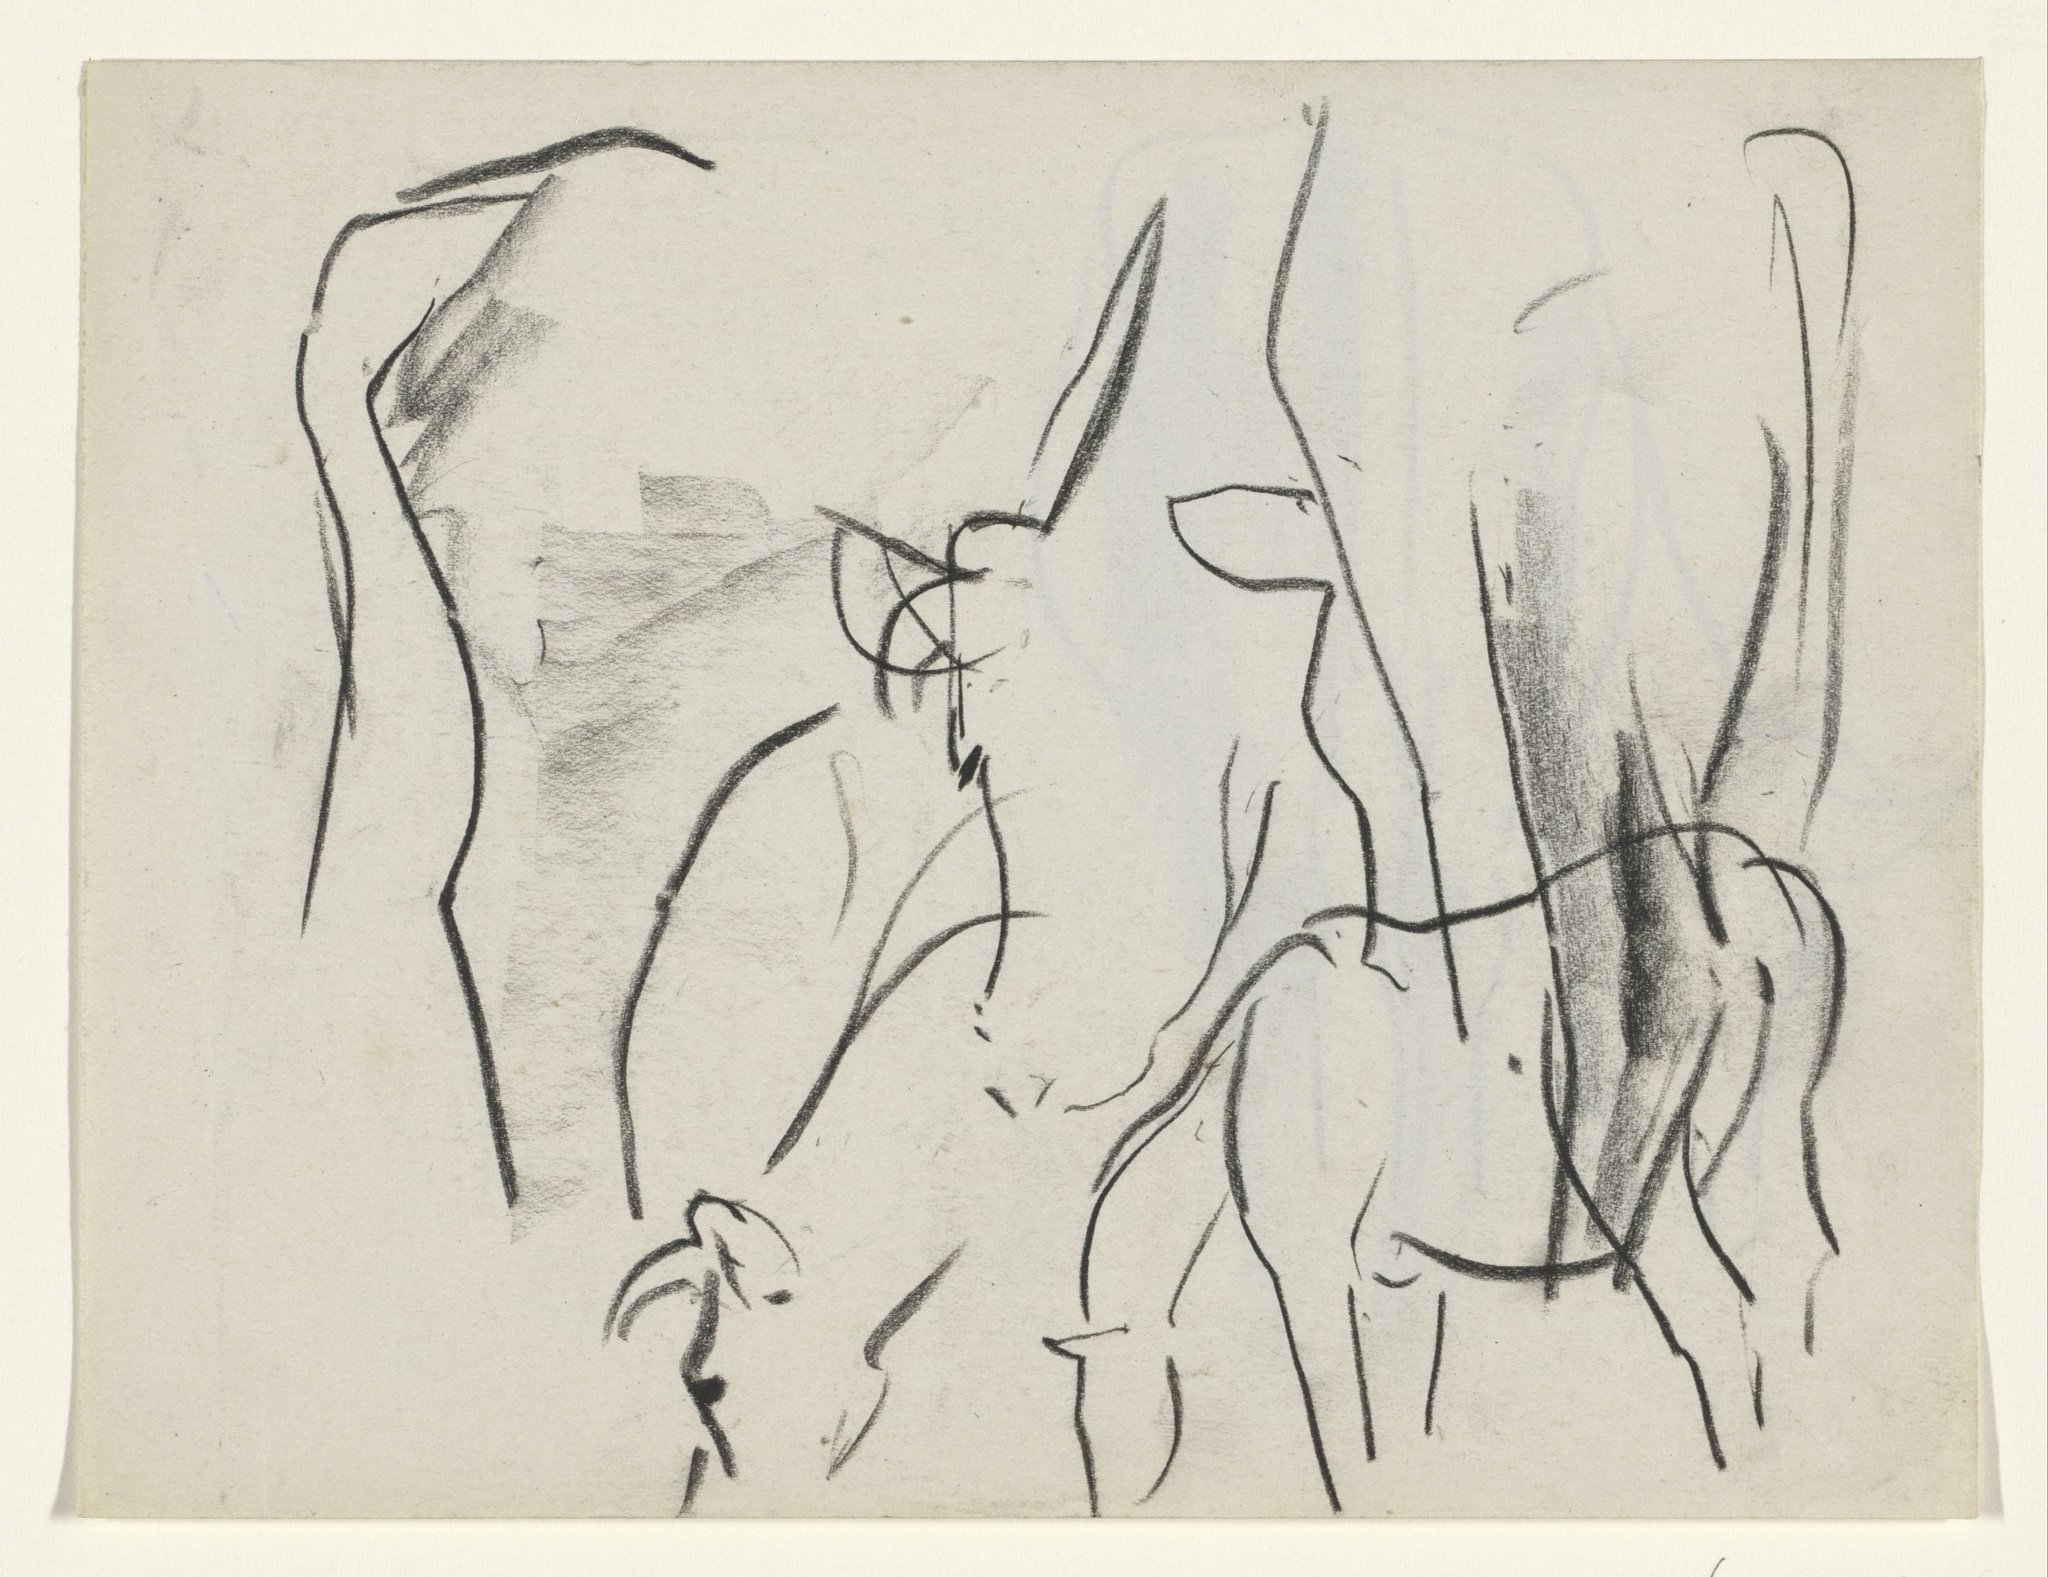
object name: drawing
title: Grazende koeien en een paard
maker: leo gestel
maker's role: draughtsman, print maker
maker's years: 1881-1941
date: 1891-1941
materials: chalk, paper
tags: cow, horse